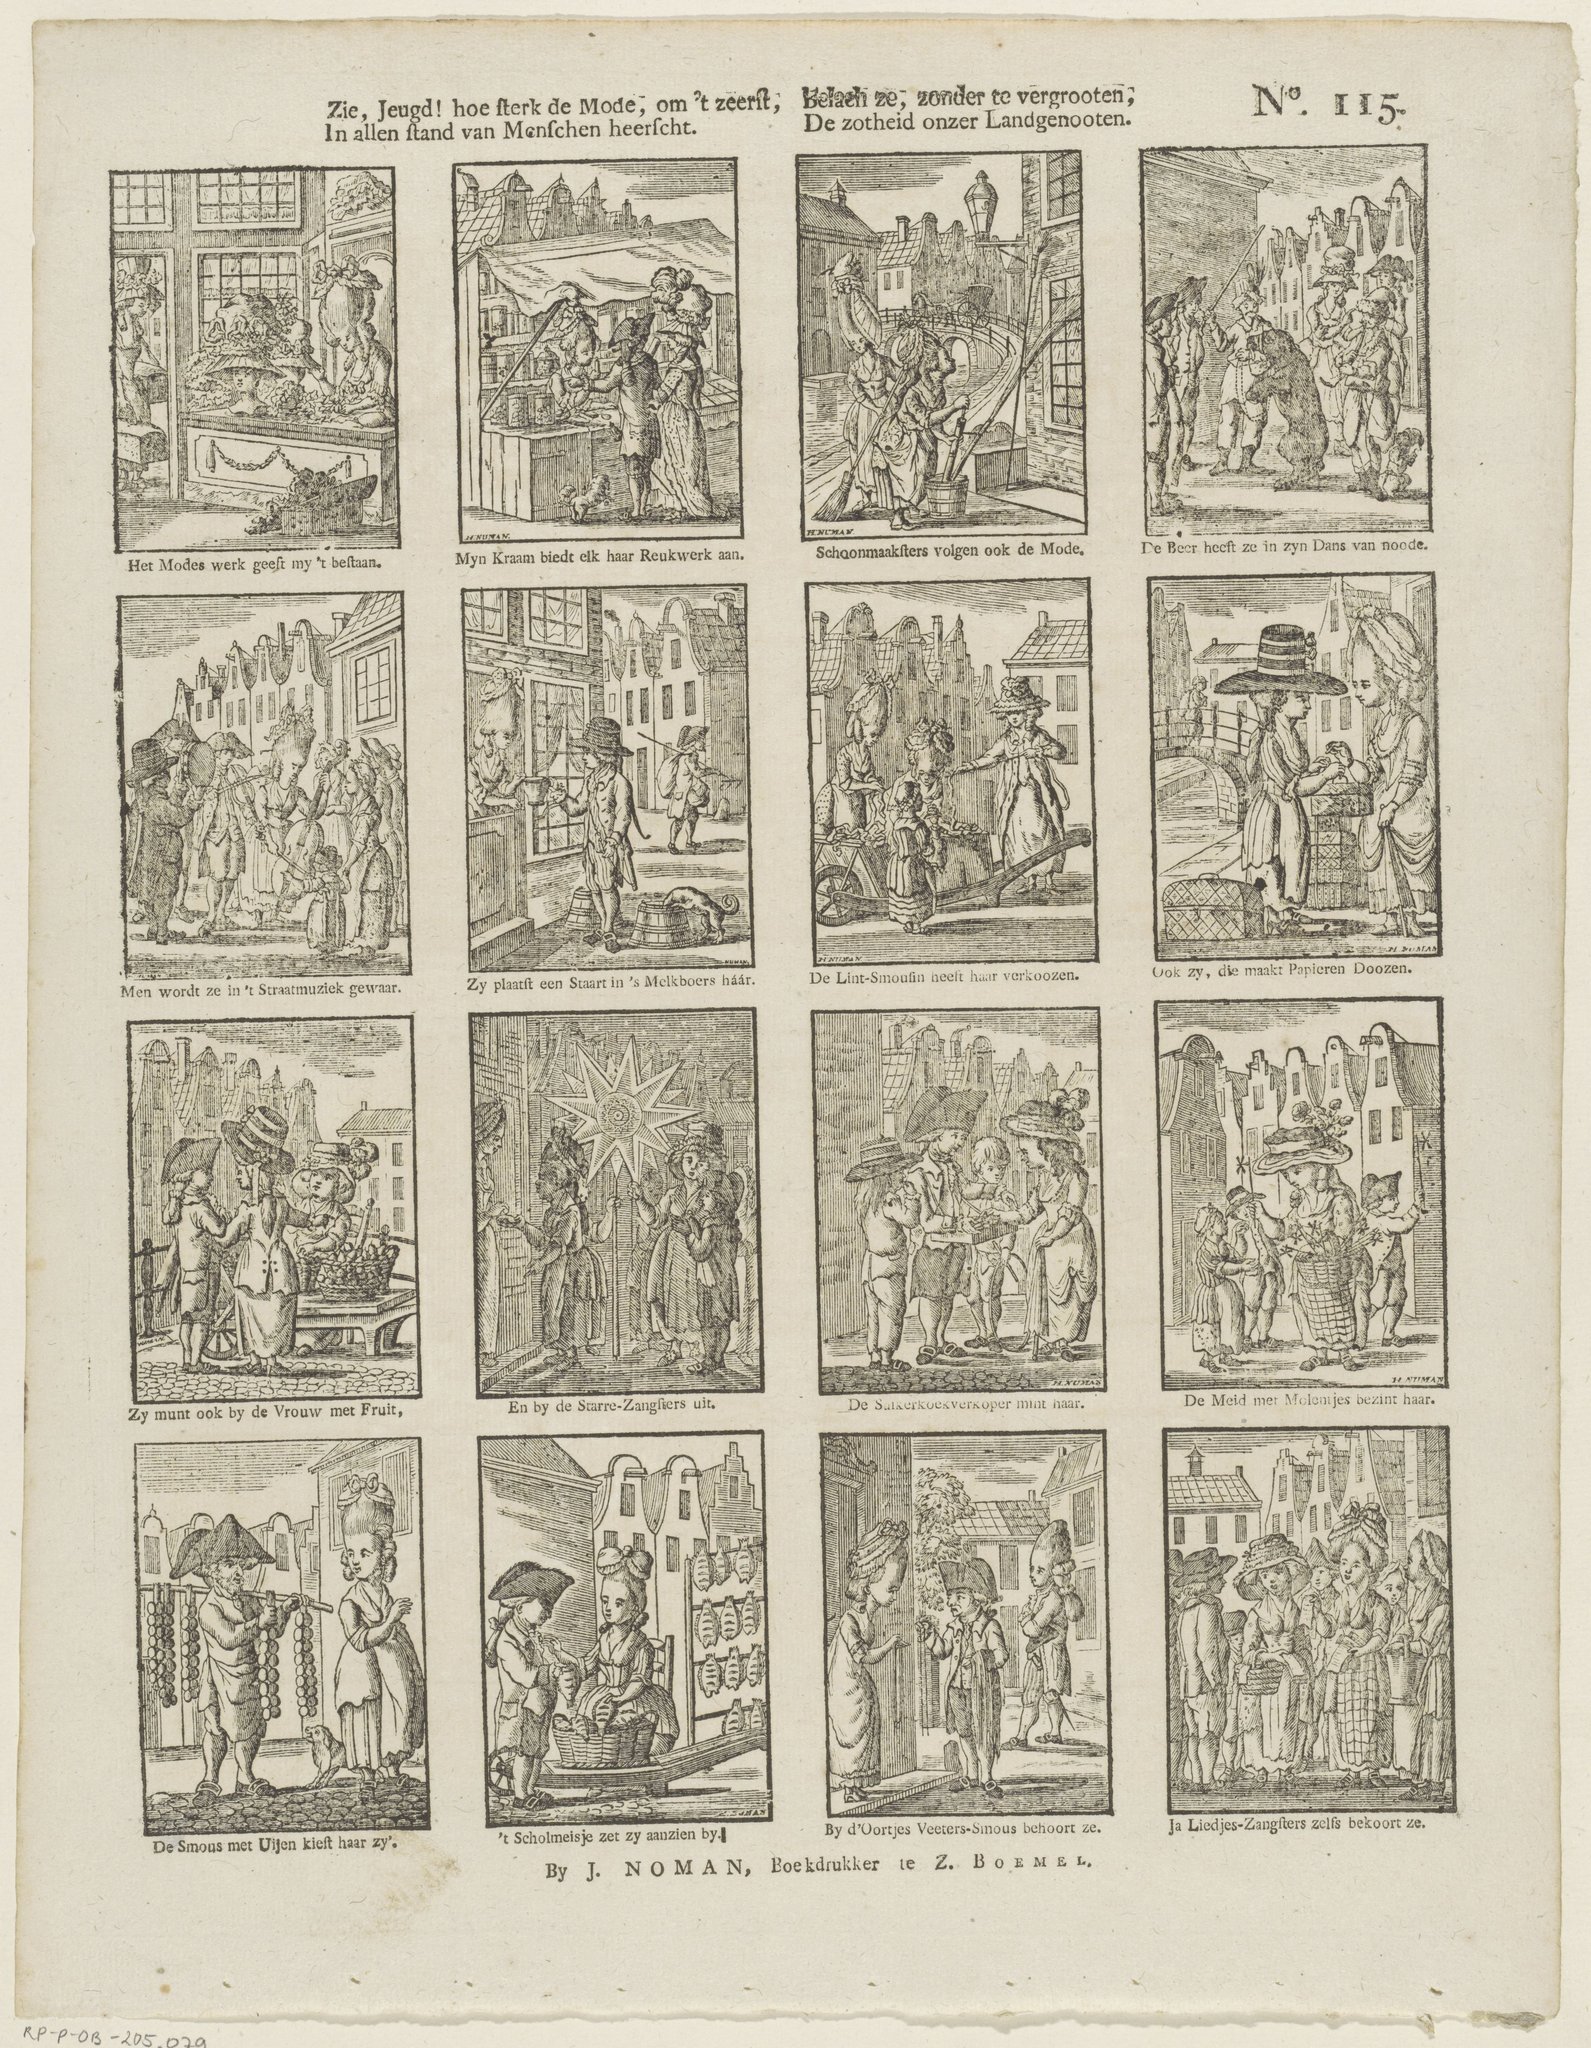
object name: cartoon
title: Zie, jeugd! hoe sterk de mode, om 't zeerst, / In allen stand van menschen heerscht. / Belach ze, zonder te vergrooten, / De zotheid onzer landgenooten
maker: johan noman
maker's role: printer, publisher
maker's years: -1833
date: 1806-1830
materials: paper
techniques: letterpress printing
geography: zaltbommel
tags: fashion, clothing, caricatures (human types), fashion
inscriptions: collector's mark: Lugt 2760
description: Spotprent op de mode met 16 voorstellingen over mensen met opvallende hoeden. Onder elke afbeelding een onderschrift. Genummerd rechtsboven: No. 115.